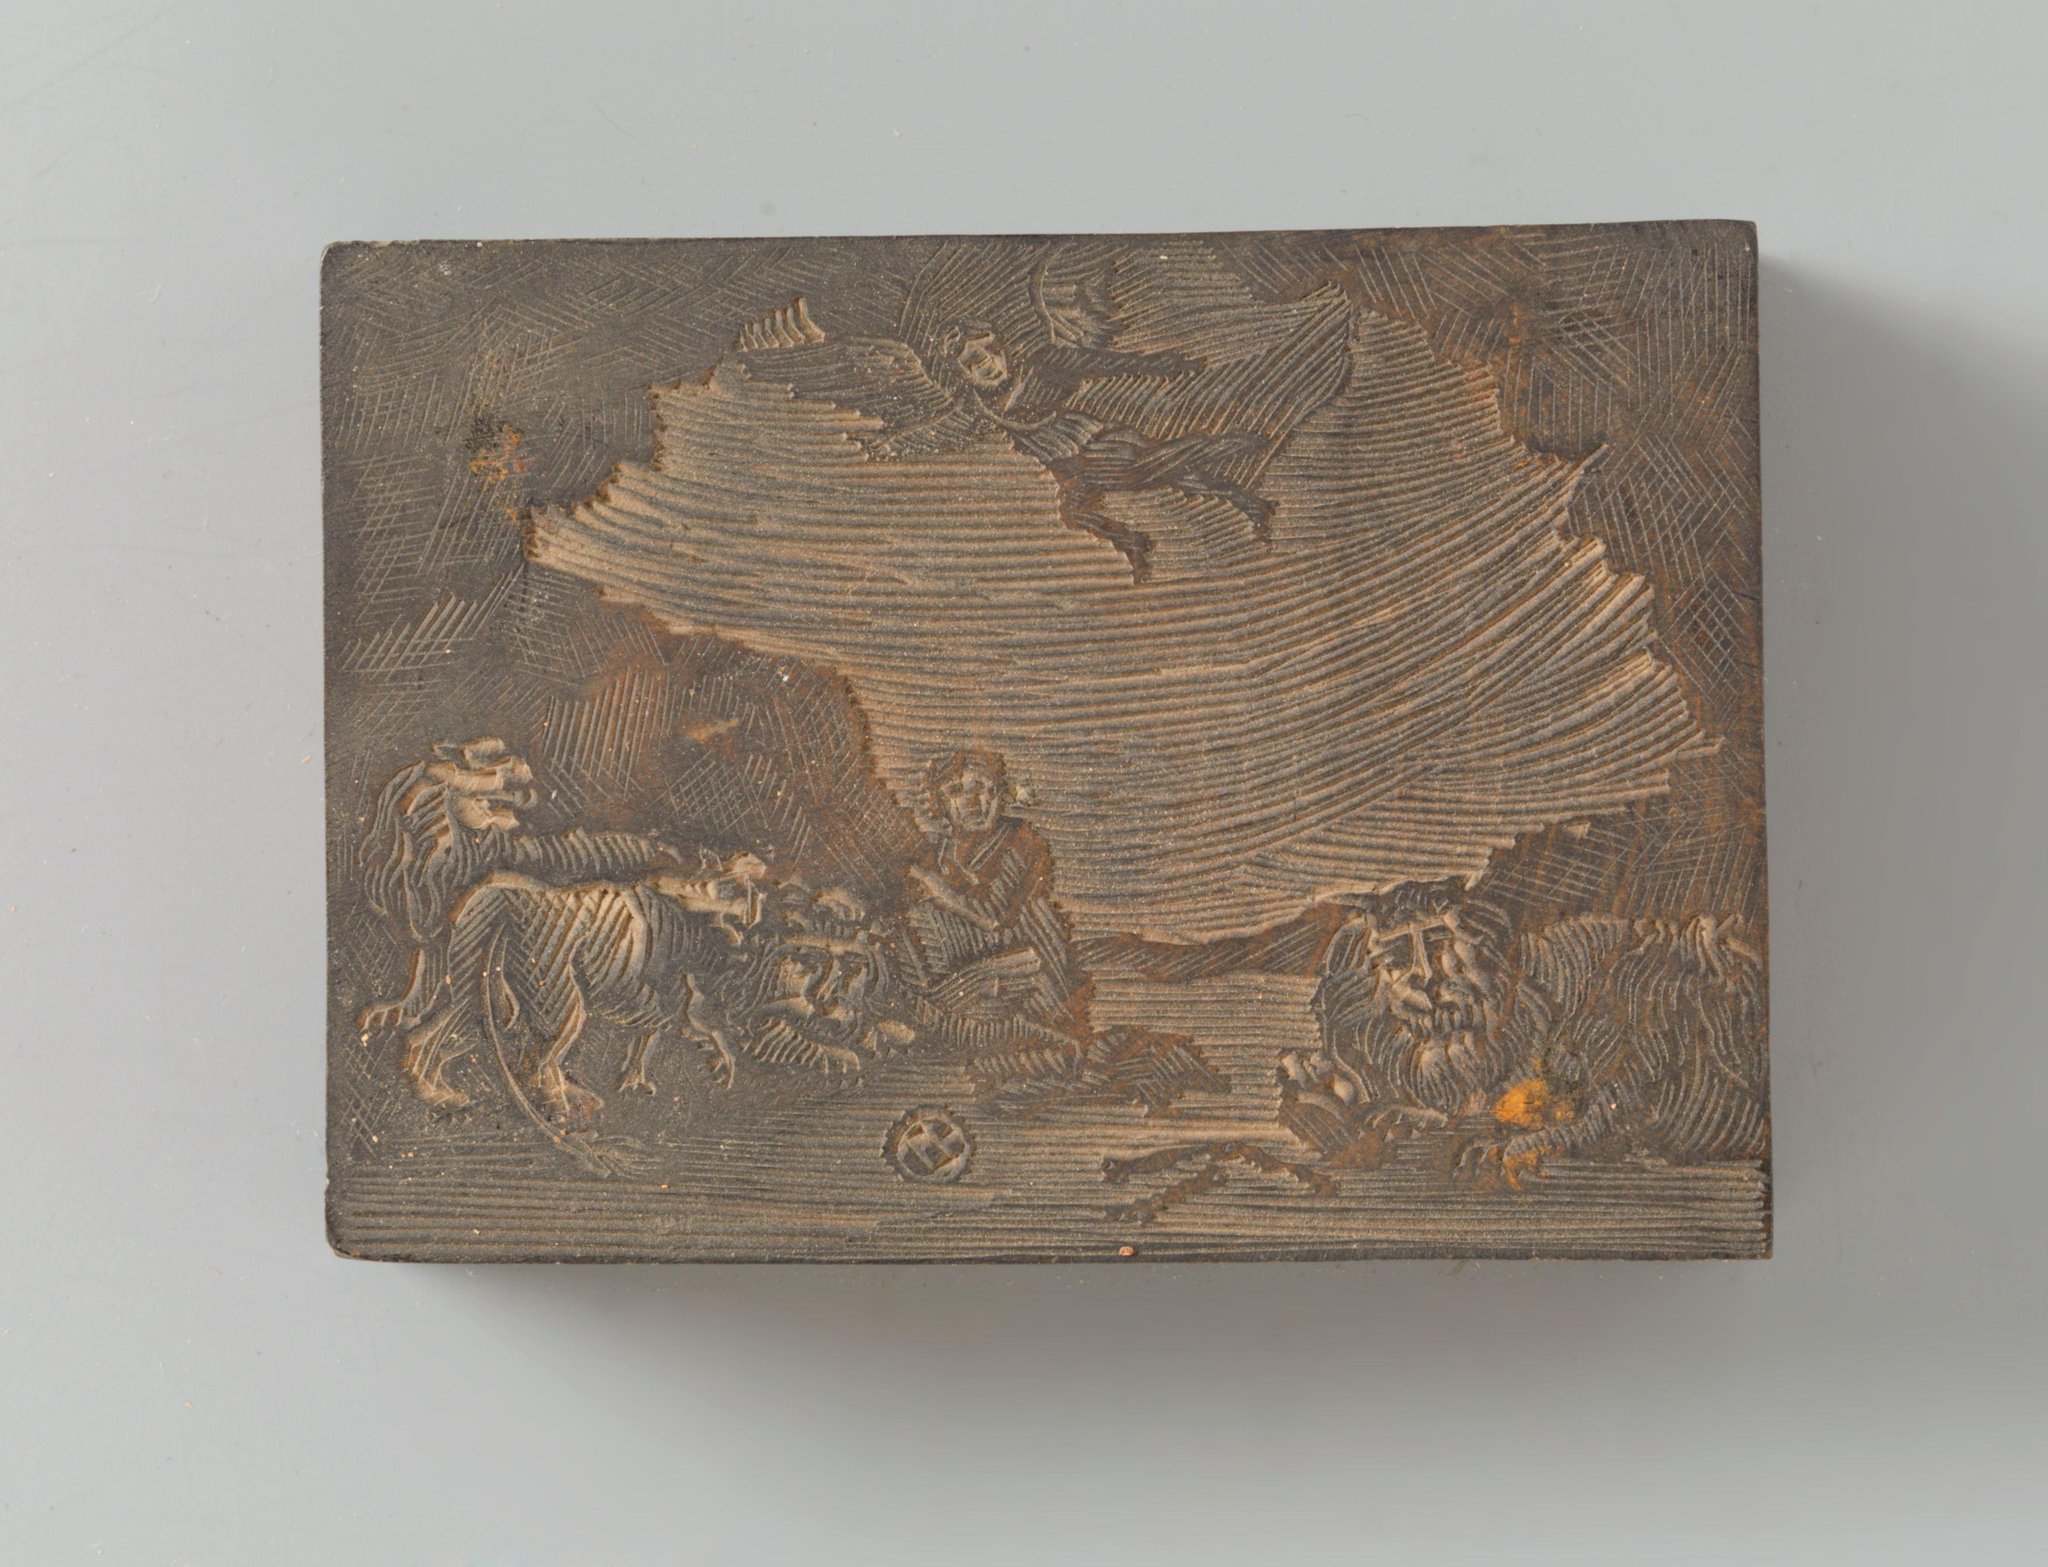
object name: wood block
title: Bijbel-illustraties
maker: Anonymous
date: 1550-1699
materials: wood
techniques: woodcut